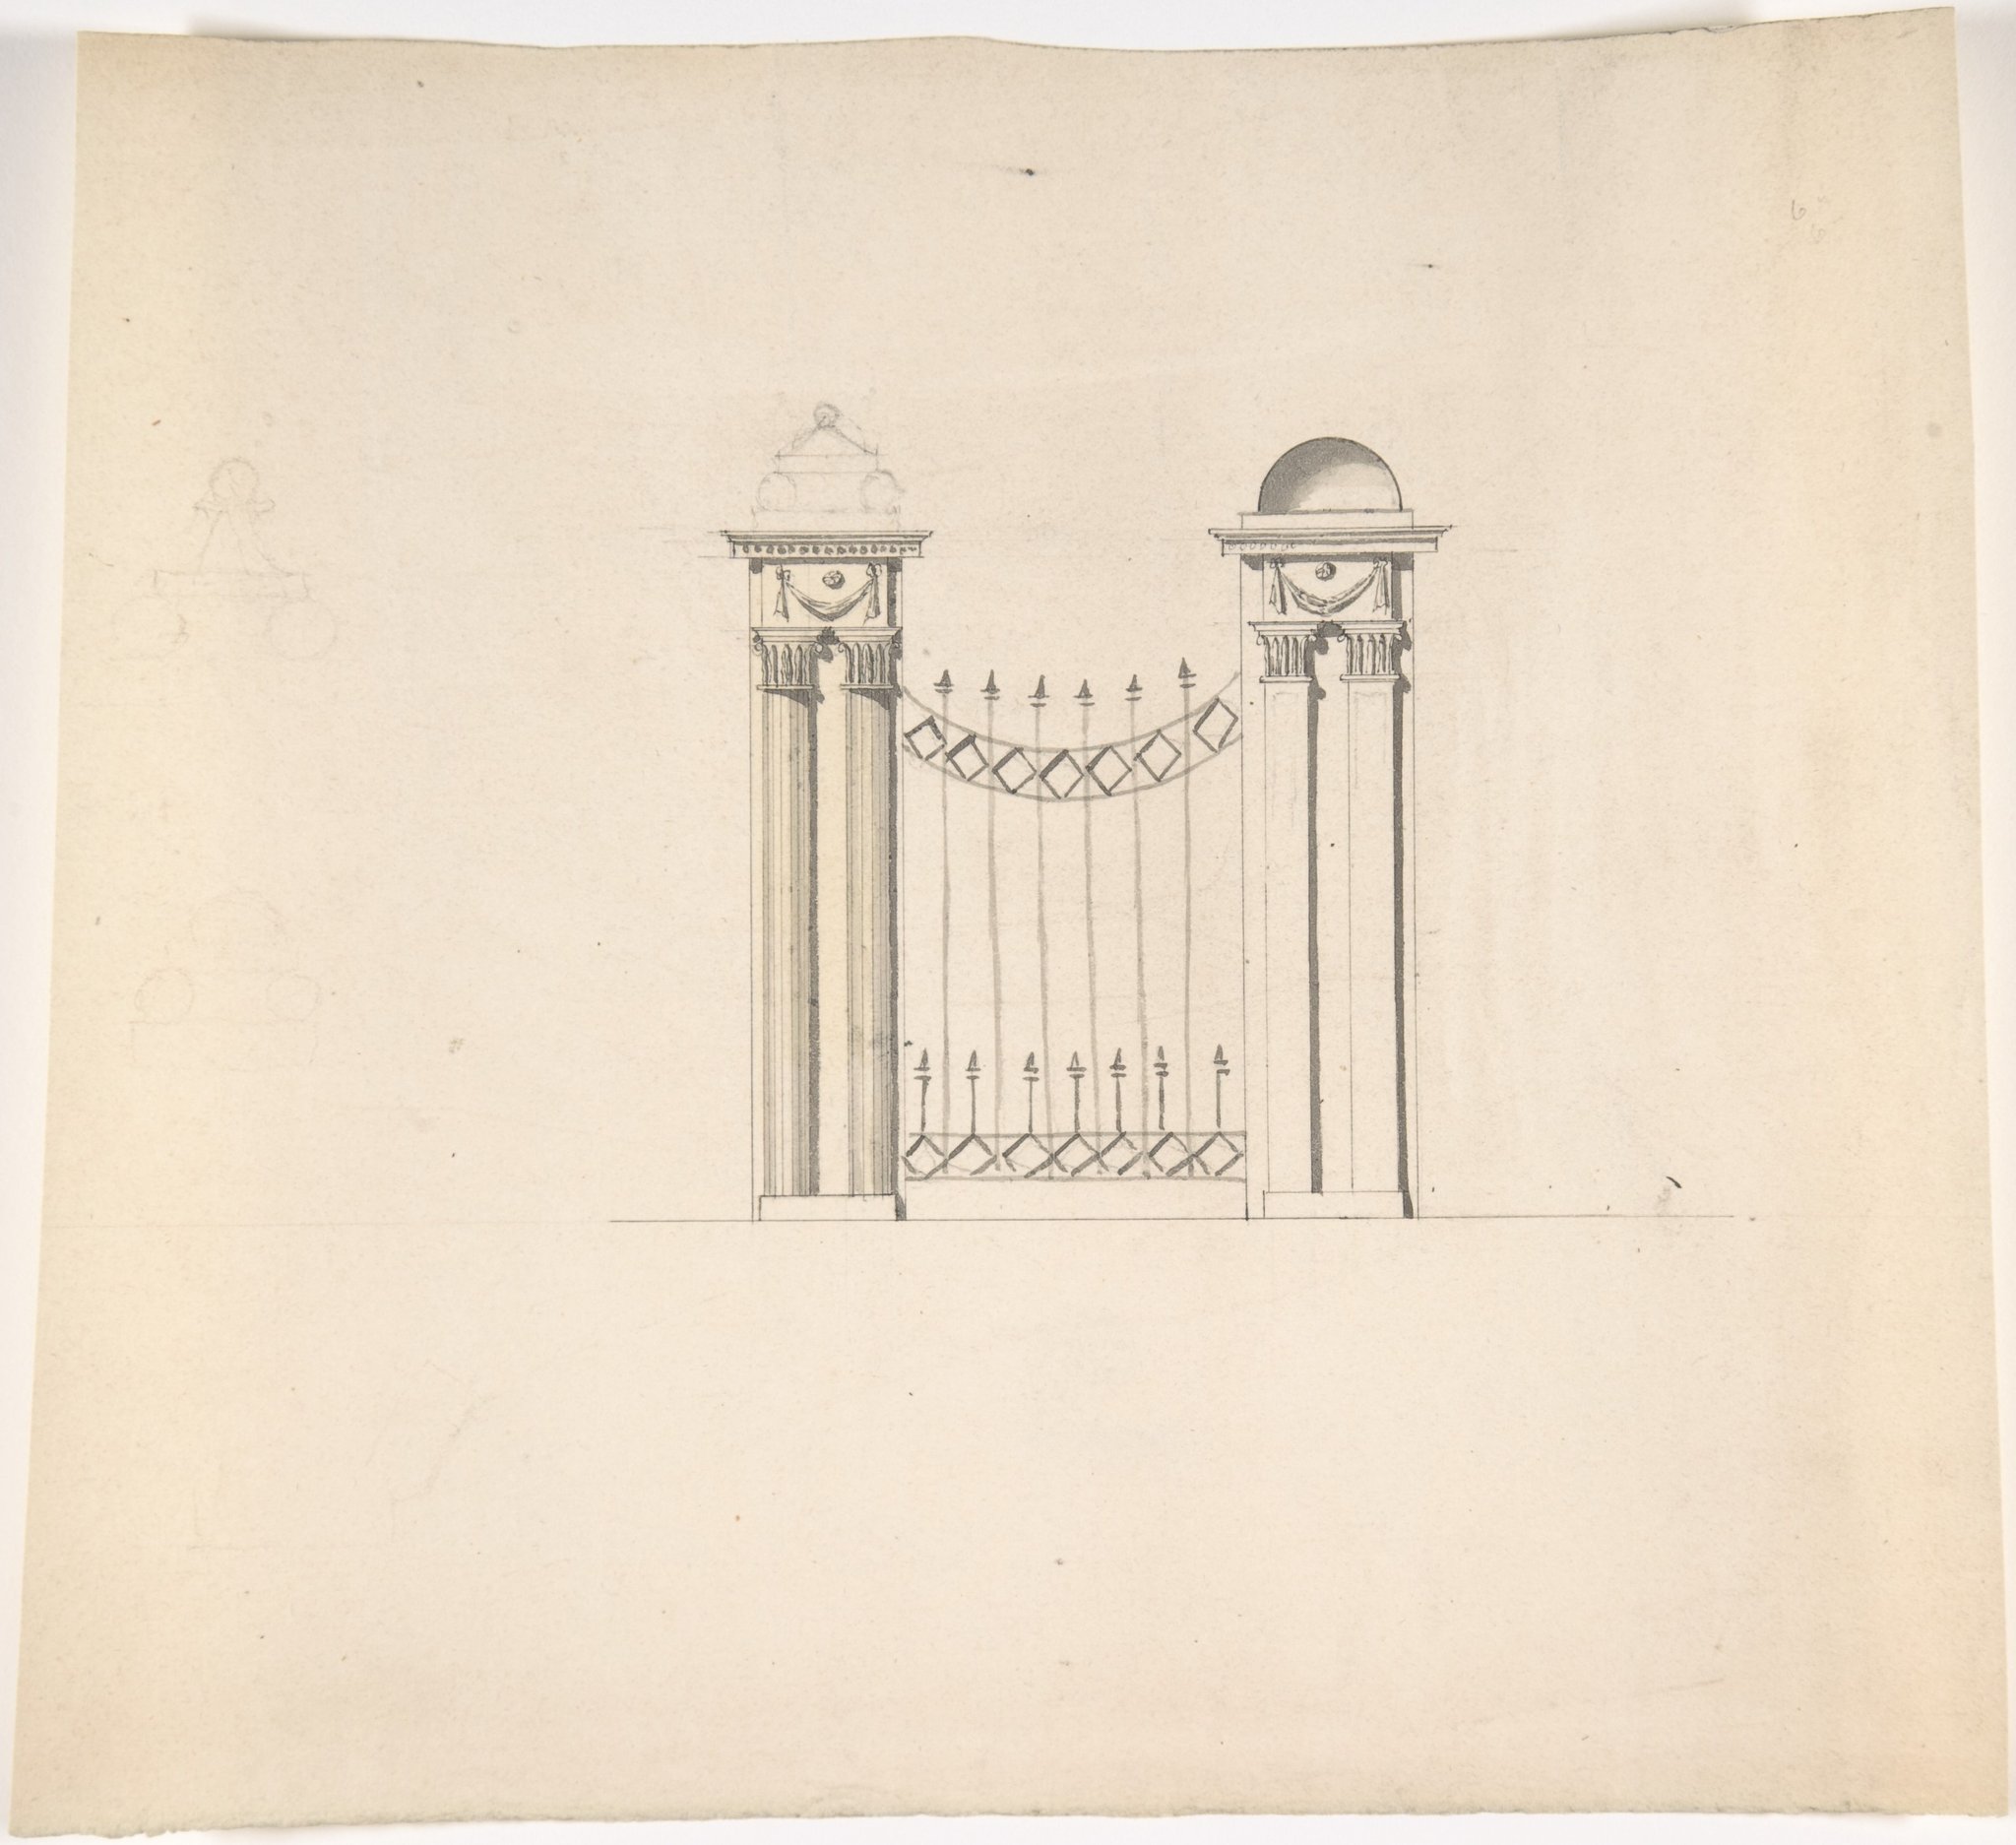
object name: drawing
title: Design for Gate Piers with Paired Pilasters and Domed Caps, and a Gate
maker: anonymous, british, 18th century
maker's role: artist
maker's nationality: british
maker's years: 1700-1800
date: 1701-1800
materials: ink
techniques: brush, pen, wash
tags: gates